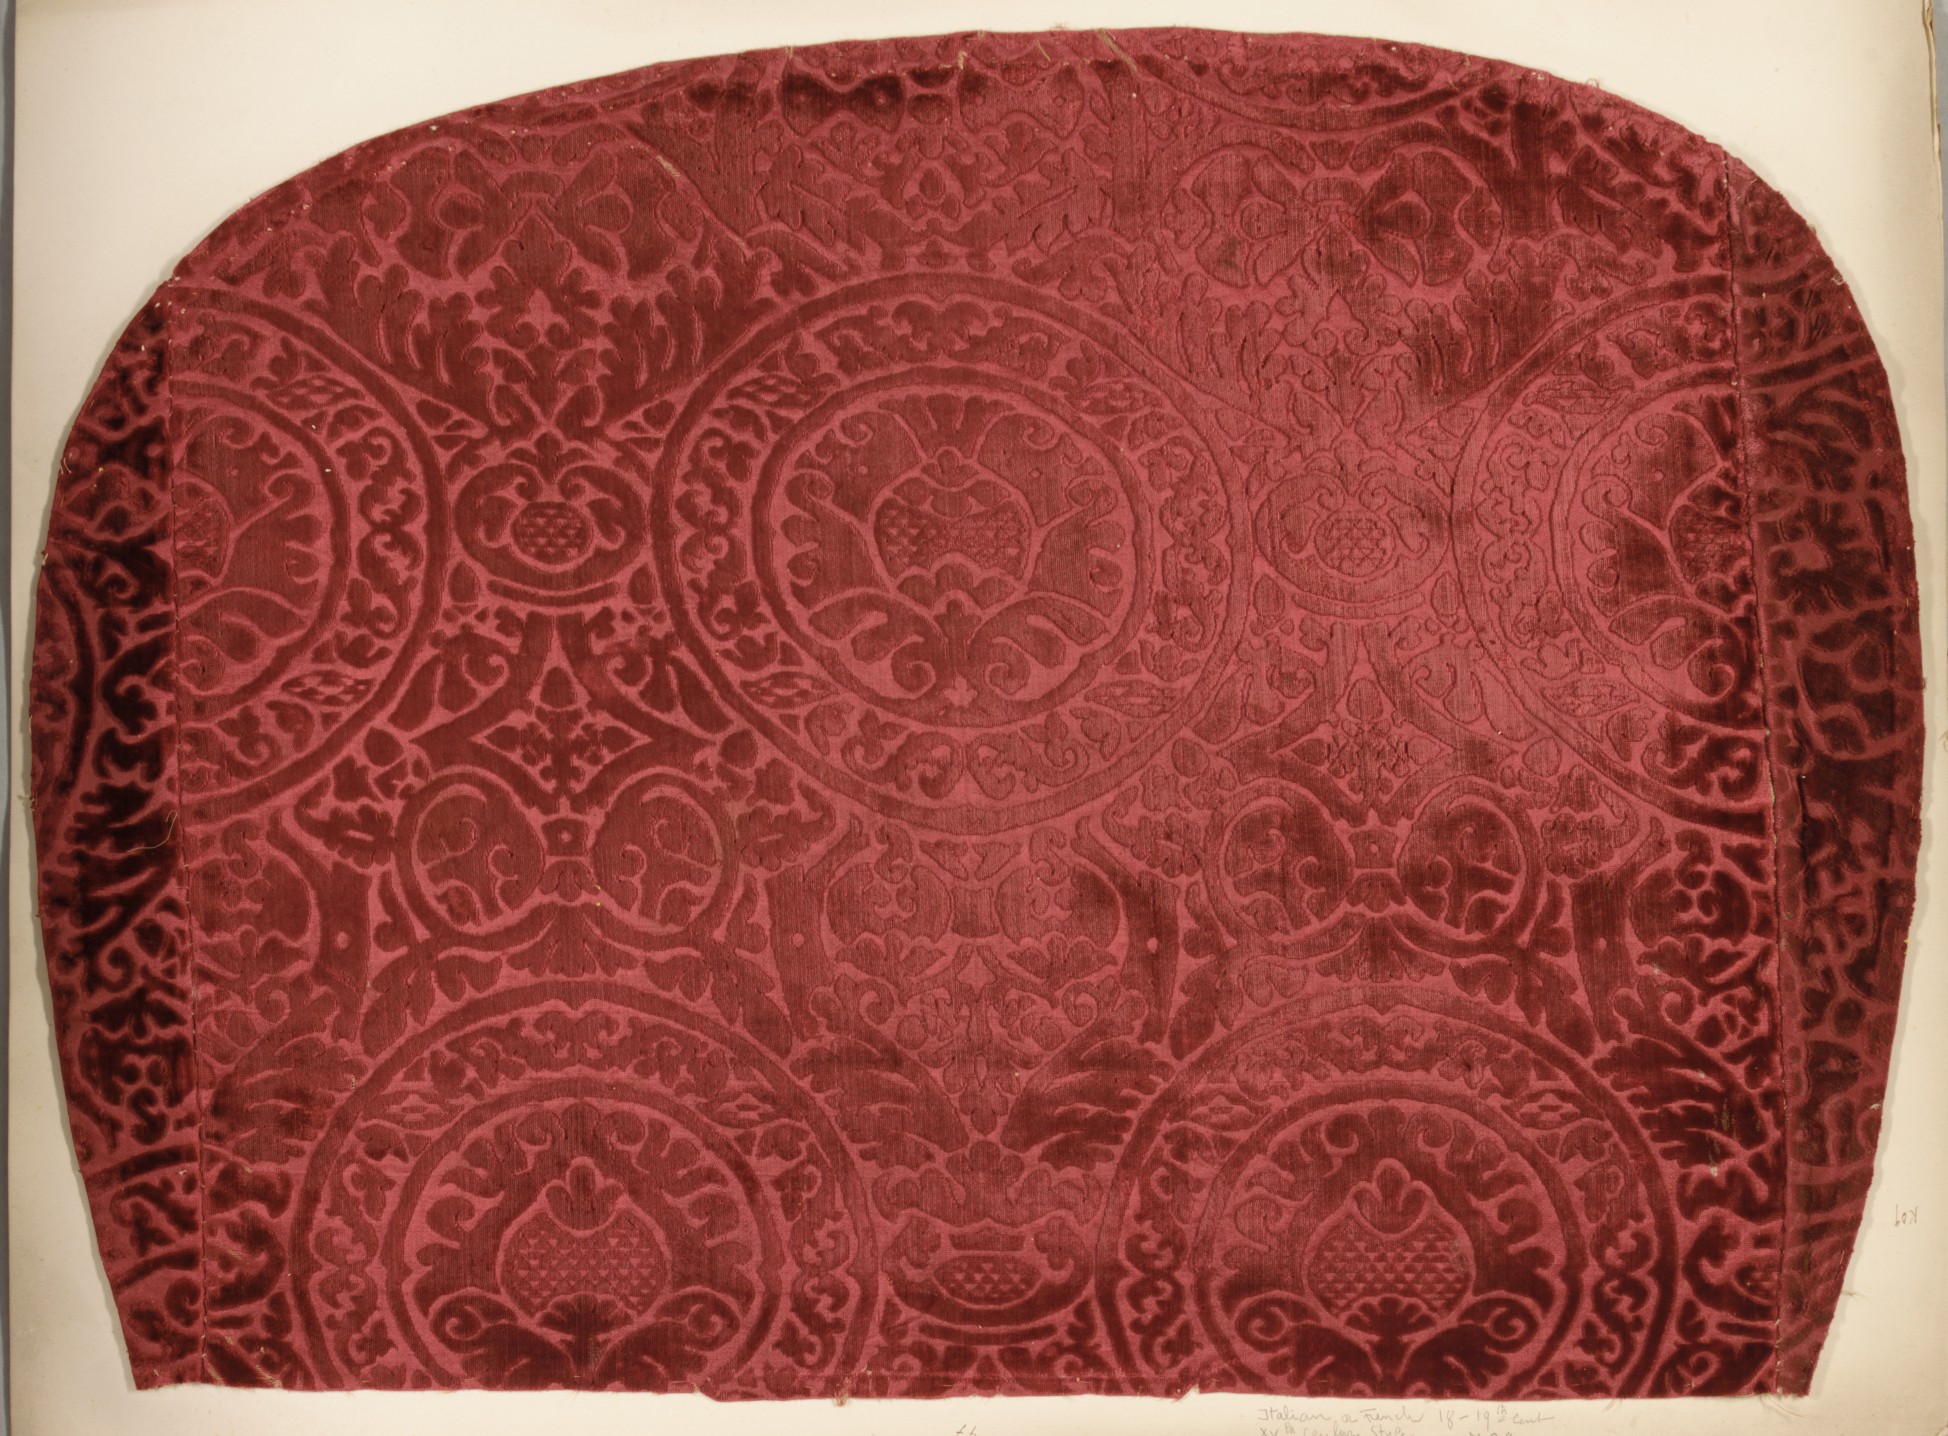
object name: fragment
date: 1701-1900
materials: silk